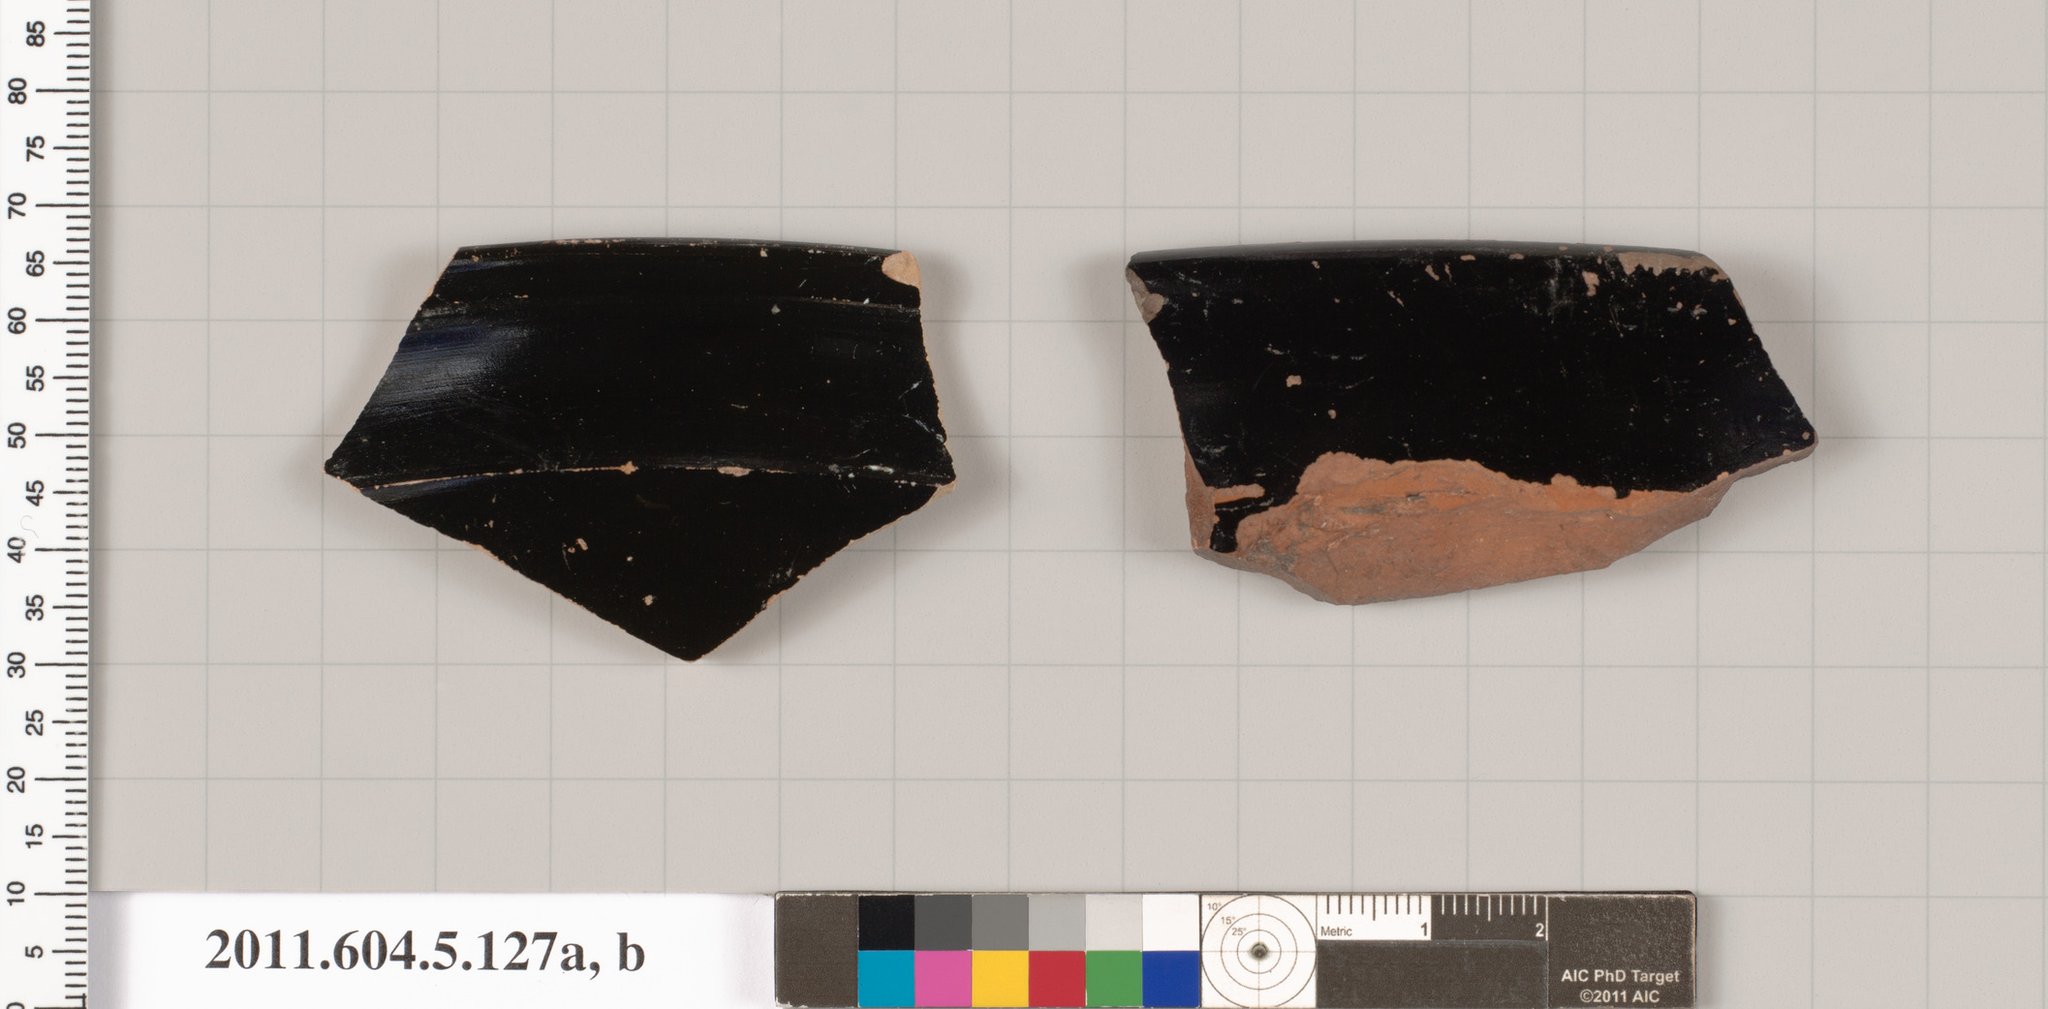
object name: kylix fragment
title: Terracotta rim fragments of stemless kylikes (drinking cups)?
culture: greek, attic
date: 470-450 BCE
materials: terracotta